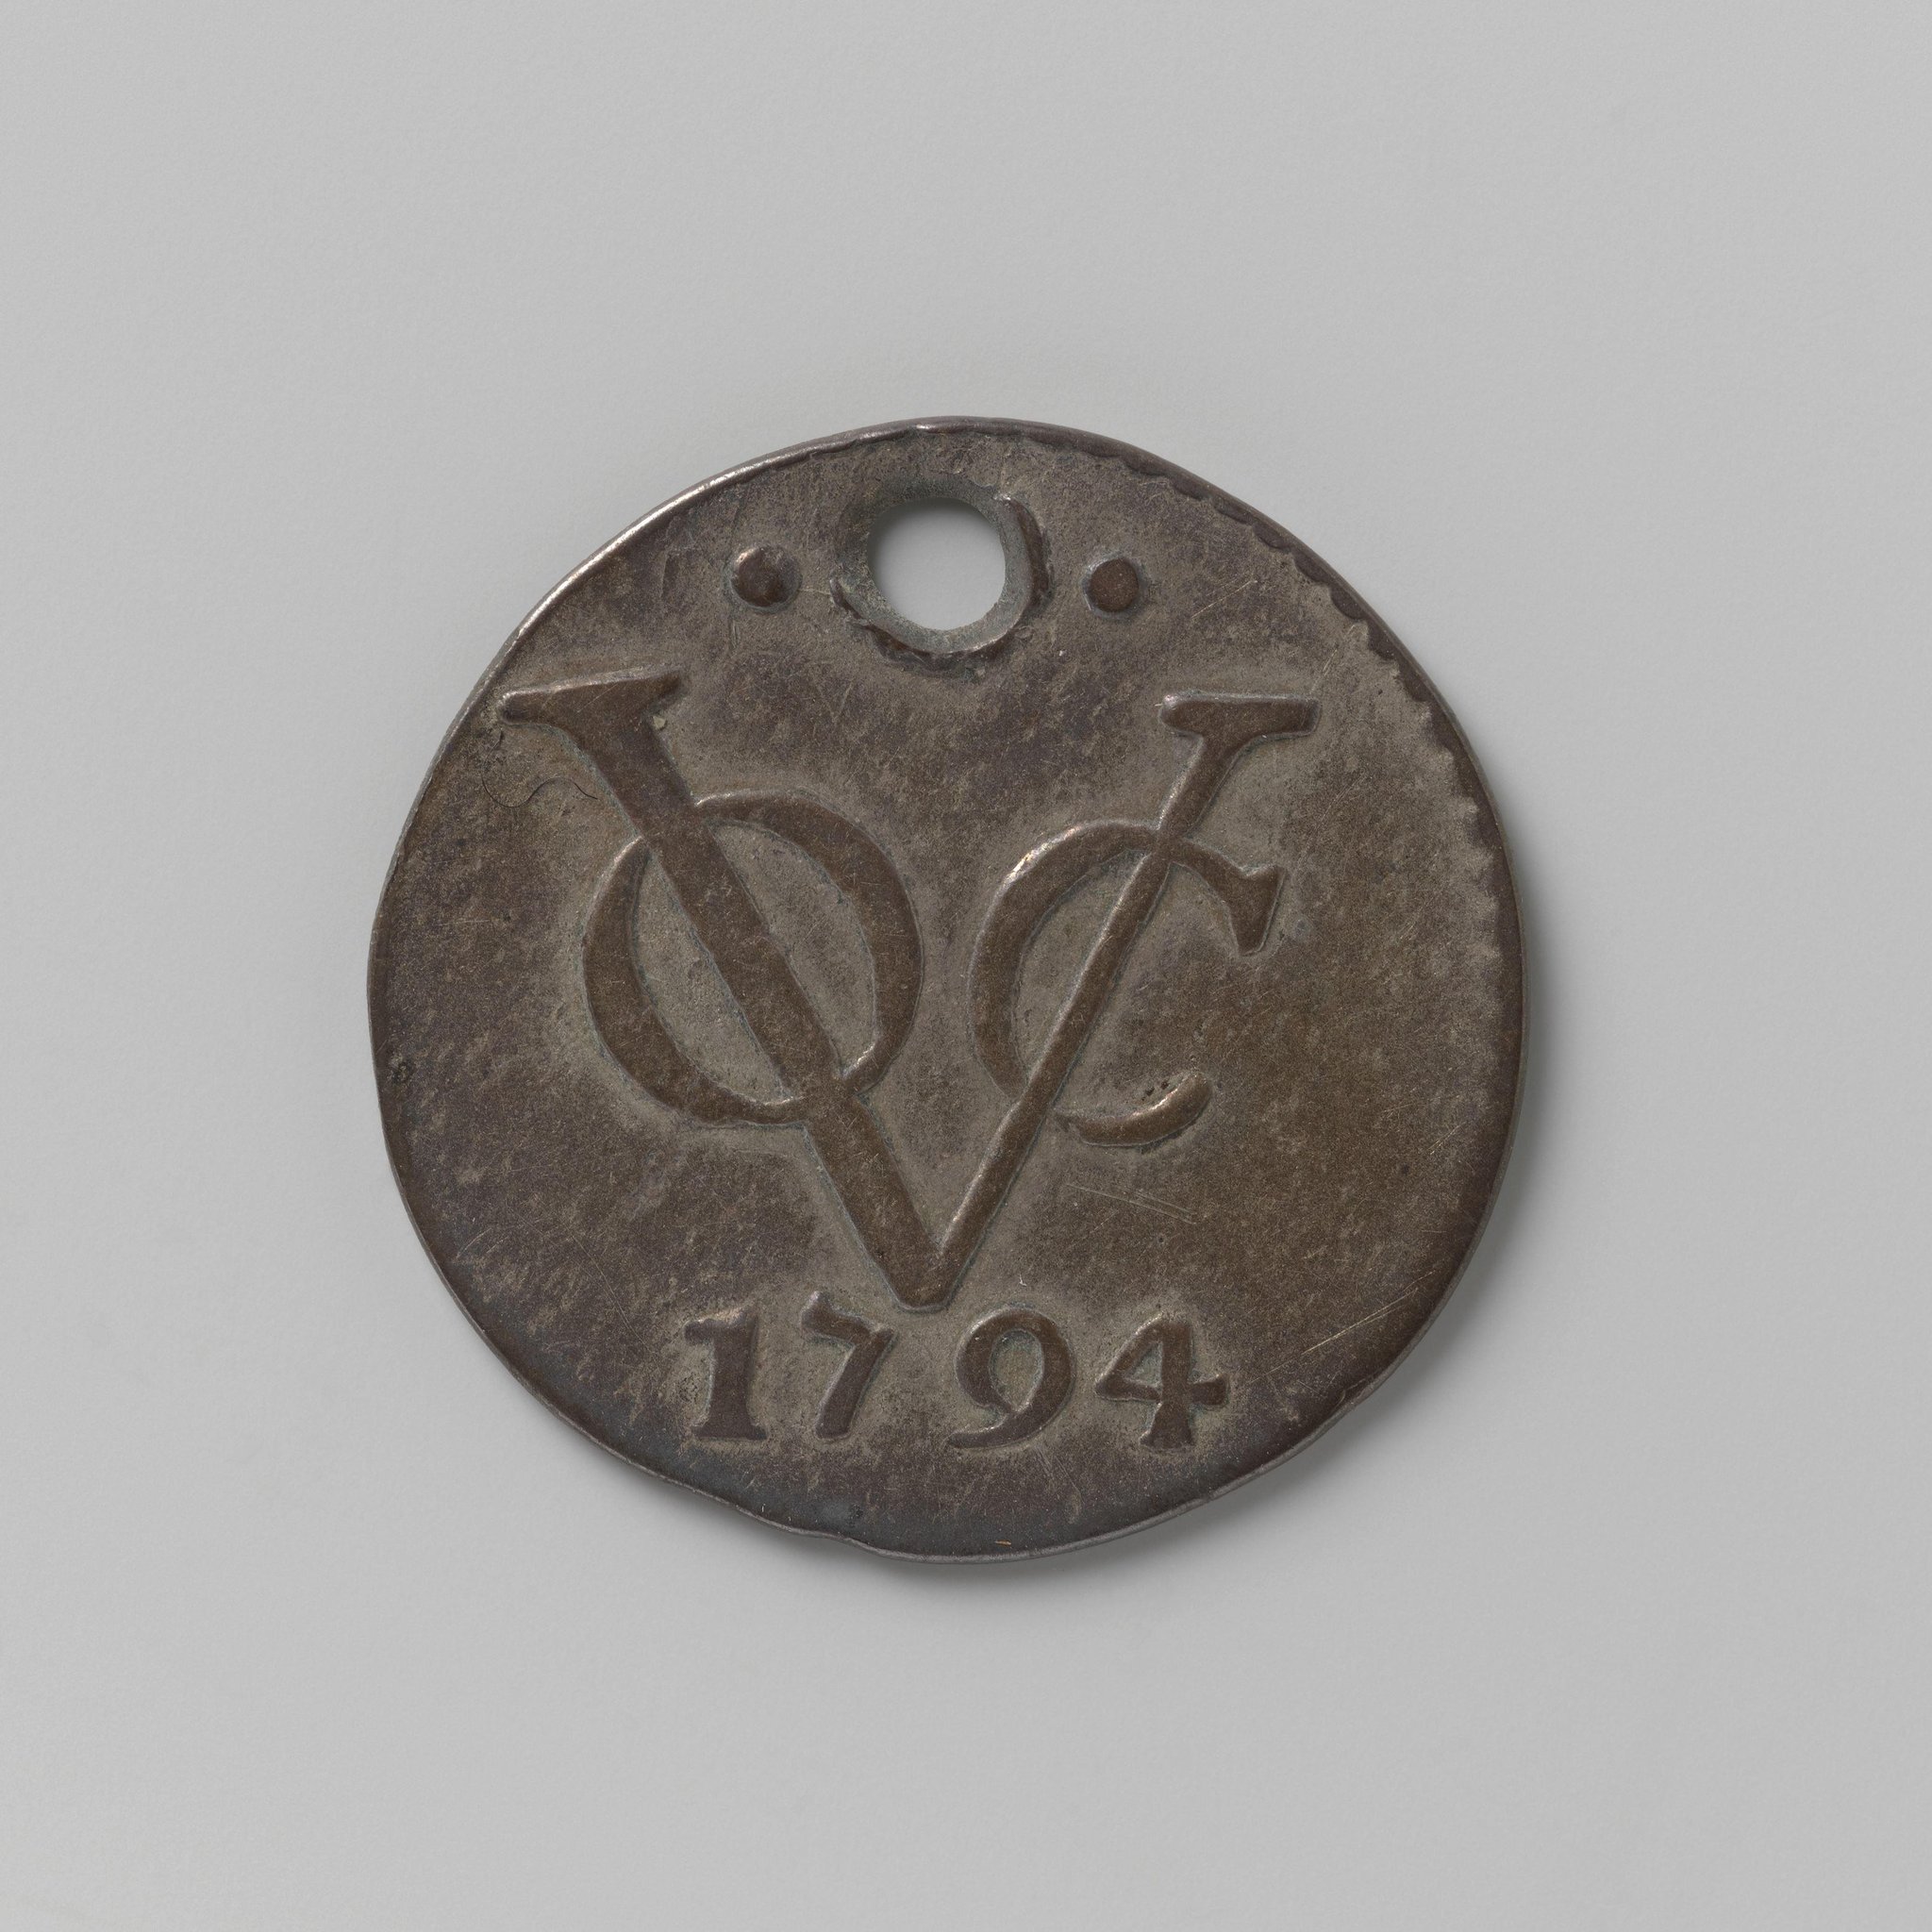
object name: coin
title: VOC, ½ duit stad Utrecht,1794. Afslag in zilver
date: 1794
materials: silver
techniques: striking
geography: utrecht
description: Zilveren munt. Voorzijde: gekroond ingebogen wapenschild van de stad Utrecht. Keerzijde: monogram van de VOC, waarboven muntteken en waaronder jaartal. Kabelrand. NB: muntplaatje doorboord.